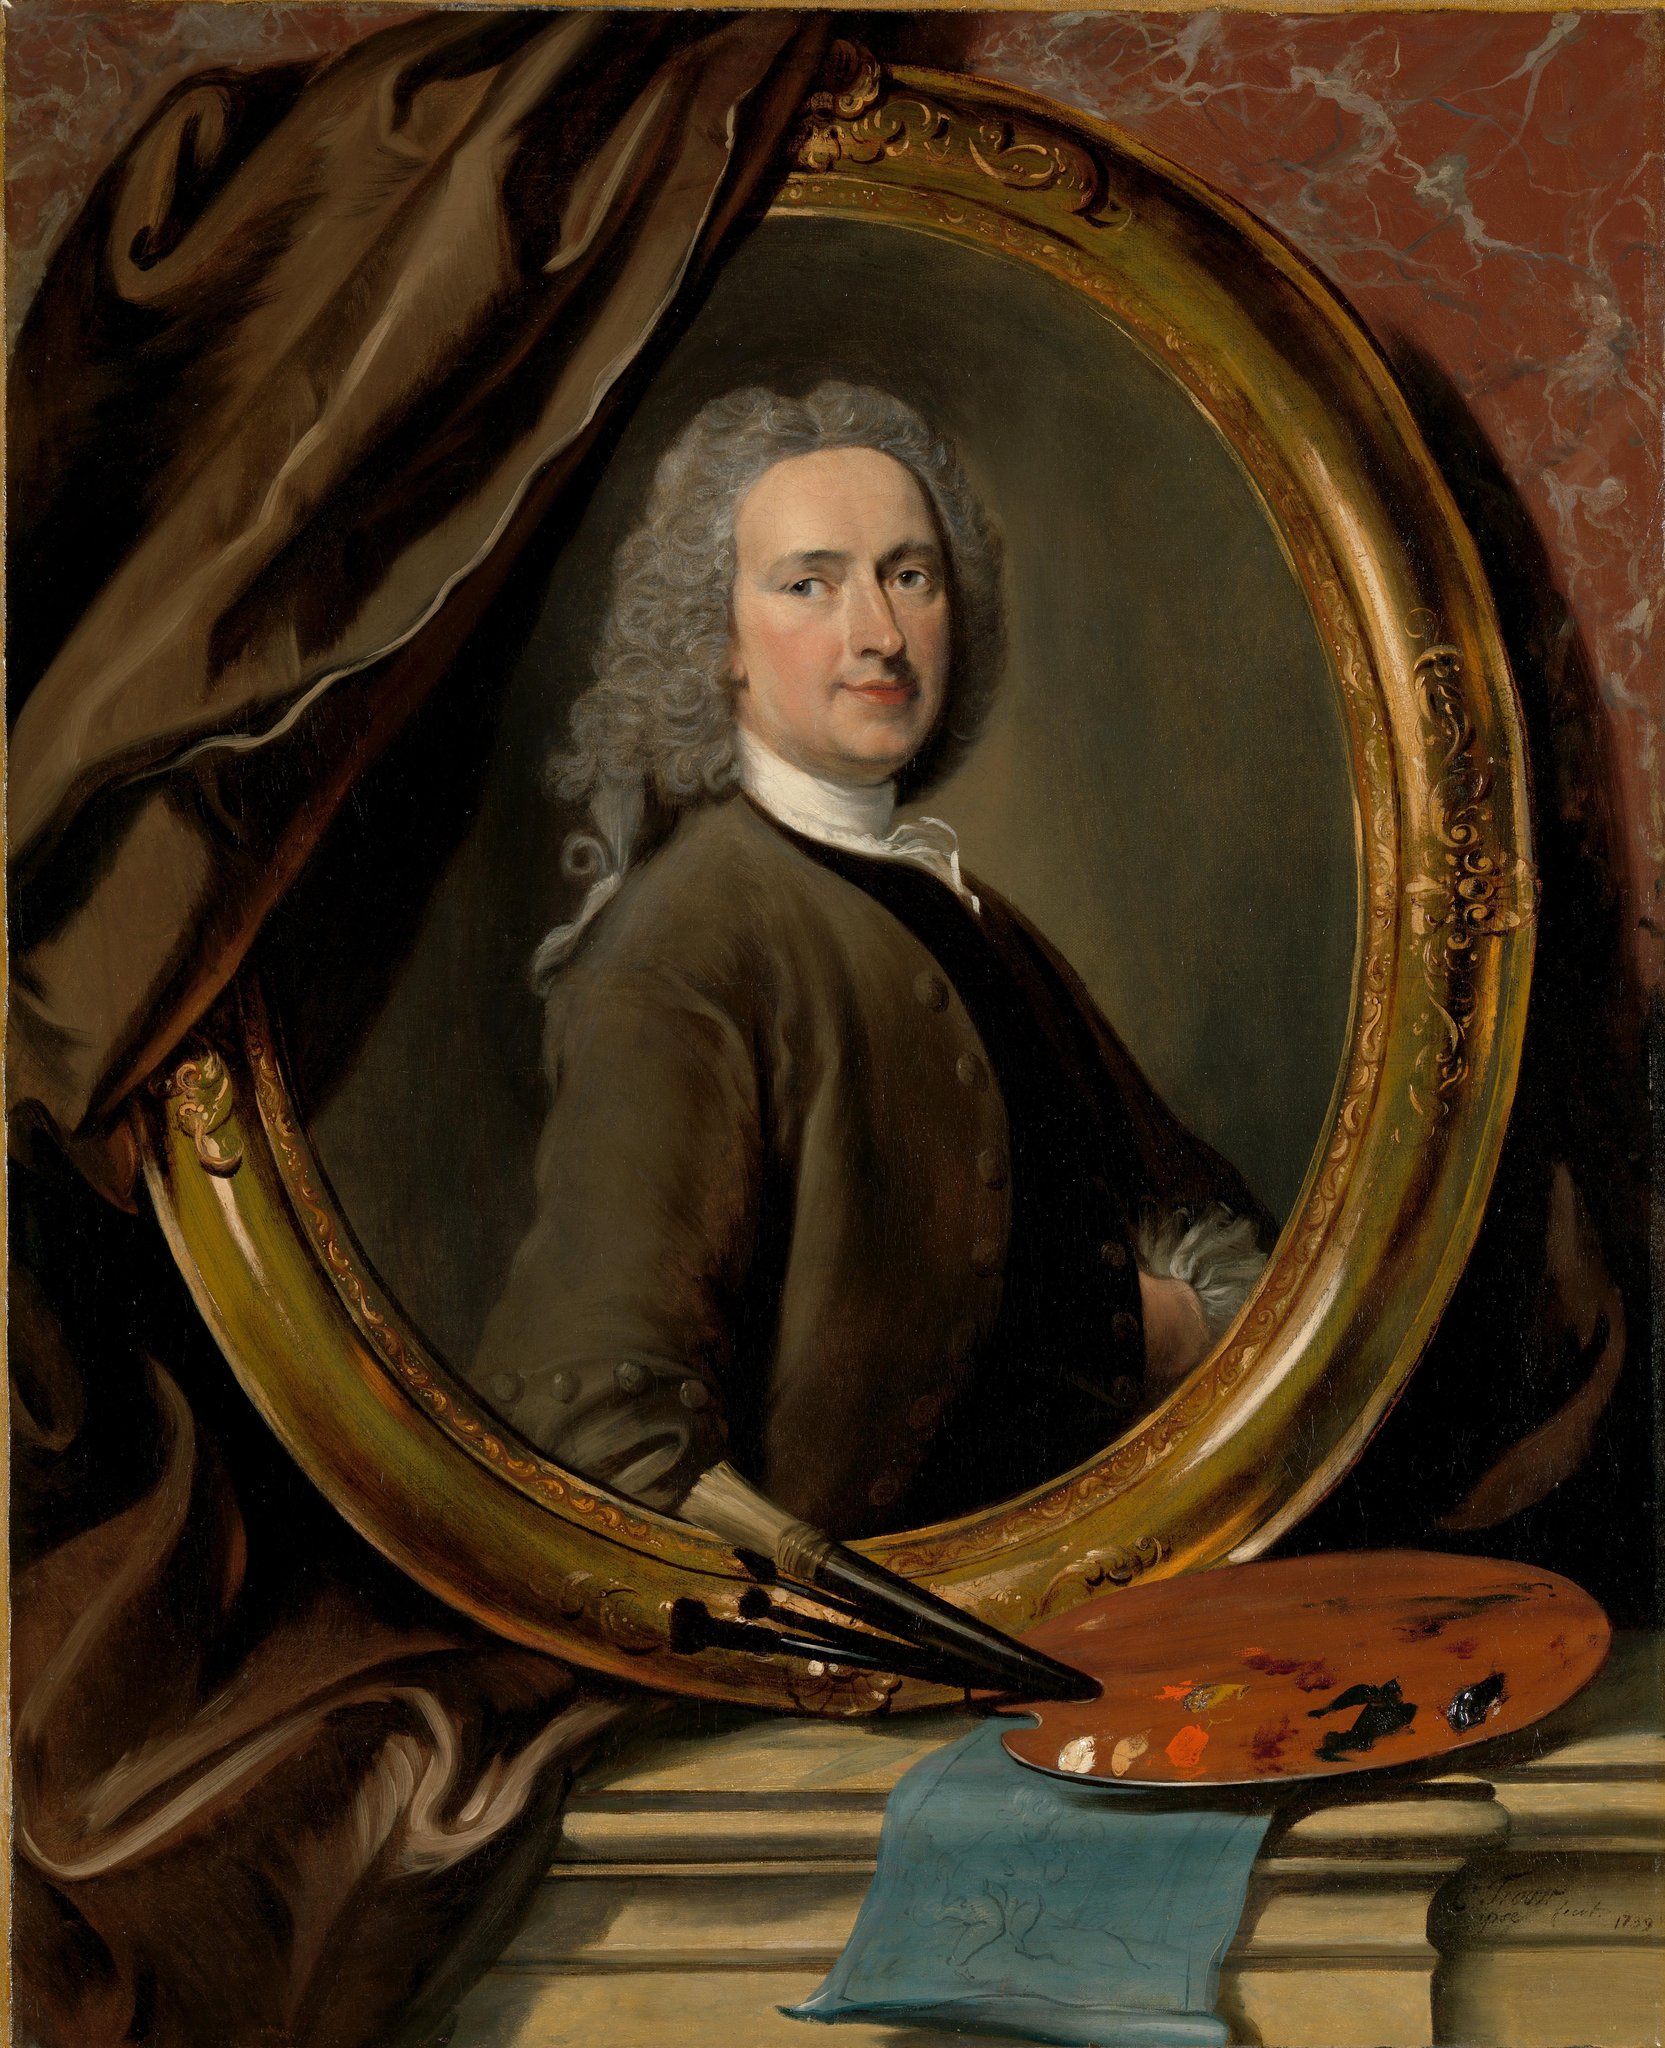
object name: painting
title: Self-Portrait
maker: cornelis troost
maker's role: draughtsman, painter, print maker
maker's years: 1696-1750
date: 1739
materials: canvas, oil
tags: amsterdam, painter, print maker, draughtsman, cornelis troost, portrait, self-portrait of painter, palette, picture, painting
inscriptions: signature and date: ‘C. Troost ipse fecit 1739’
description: As a former actor and scene painter, Troost understood illusion. In this self-portrait he gazes from a mirror at himself and at us. The curtain, pedestal, palette and drawing on blue paper create a sense of depth. Every detail testifies to his technical skill. Notice how he conveyed the fine batiste cloth of his fashionable jabot – the frill of ruffles attached to his shirt – with a single stroke of white paint.